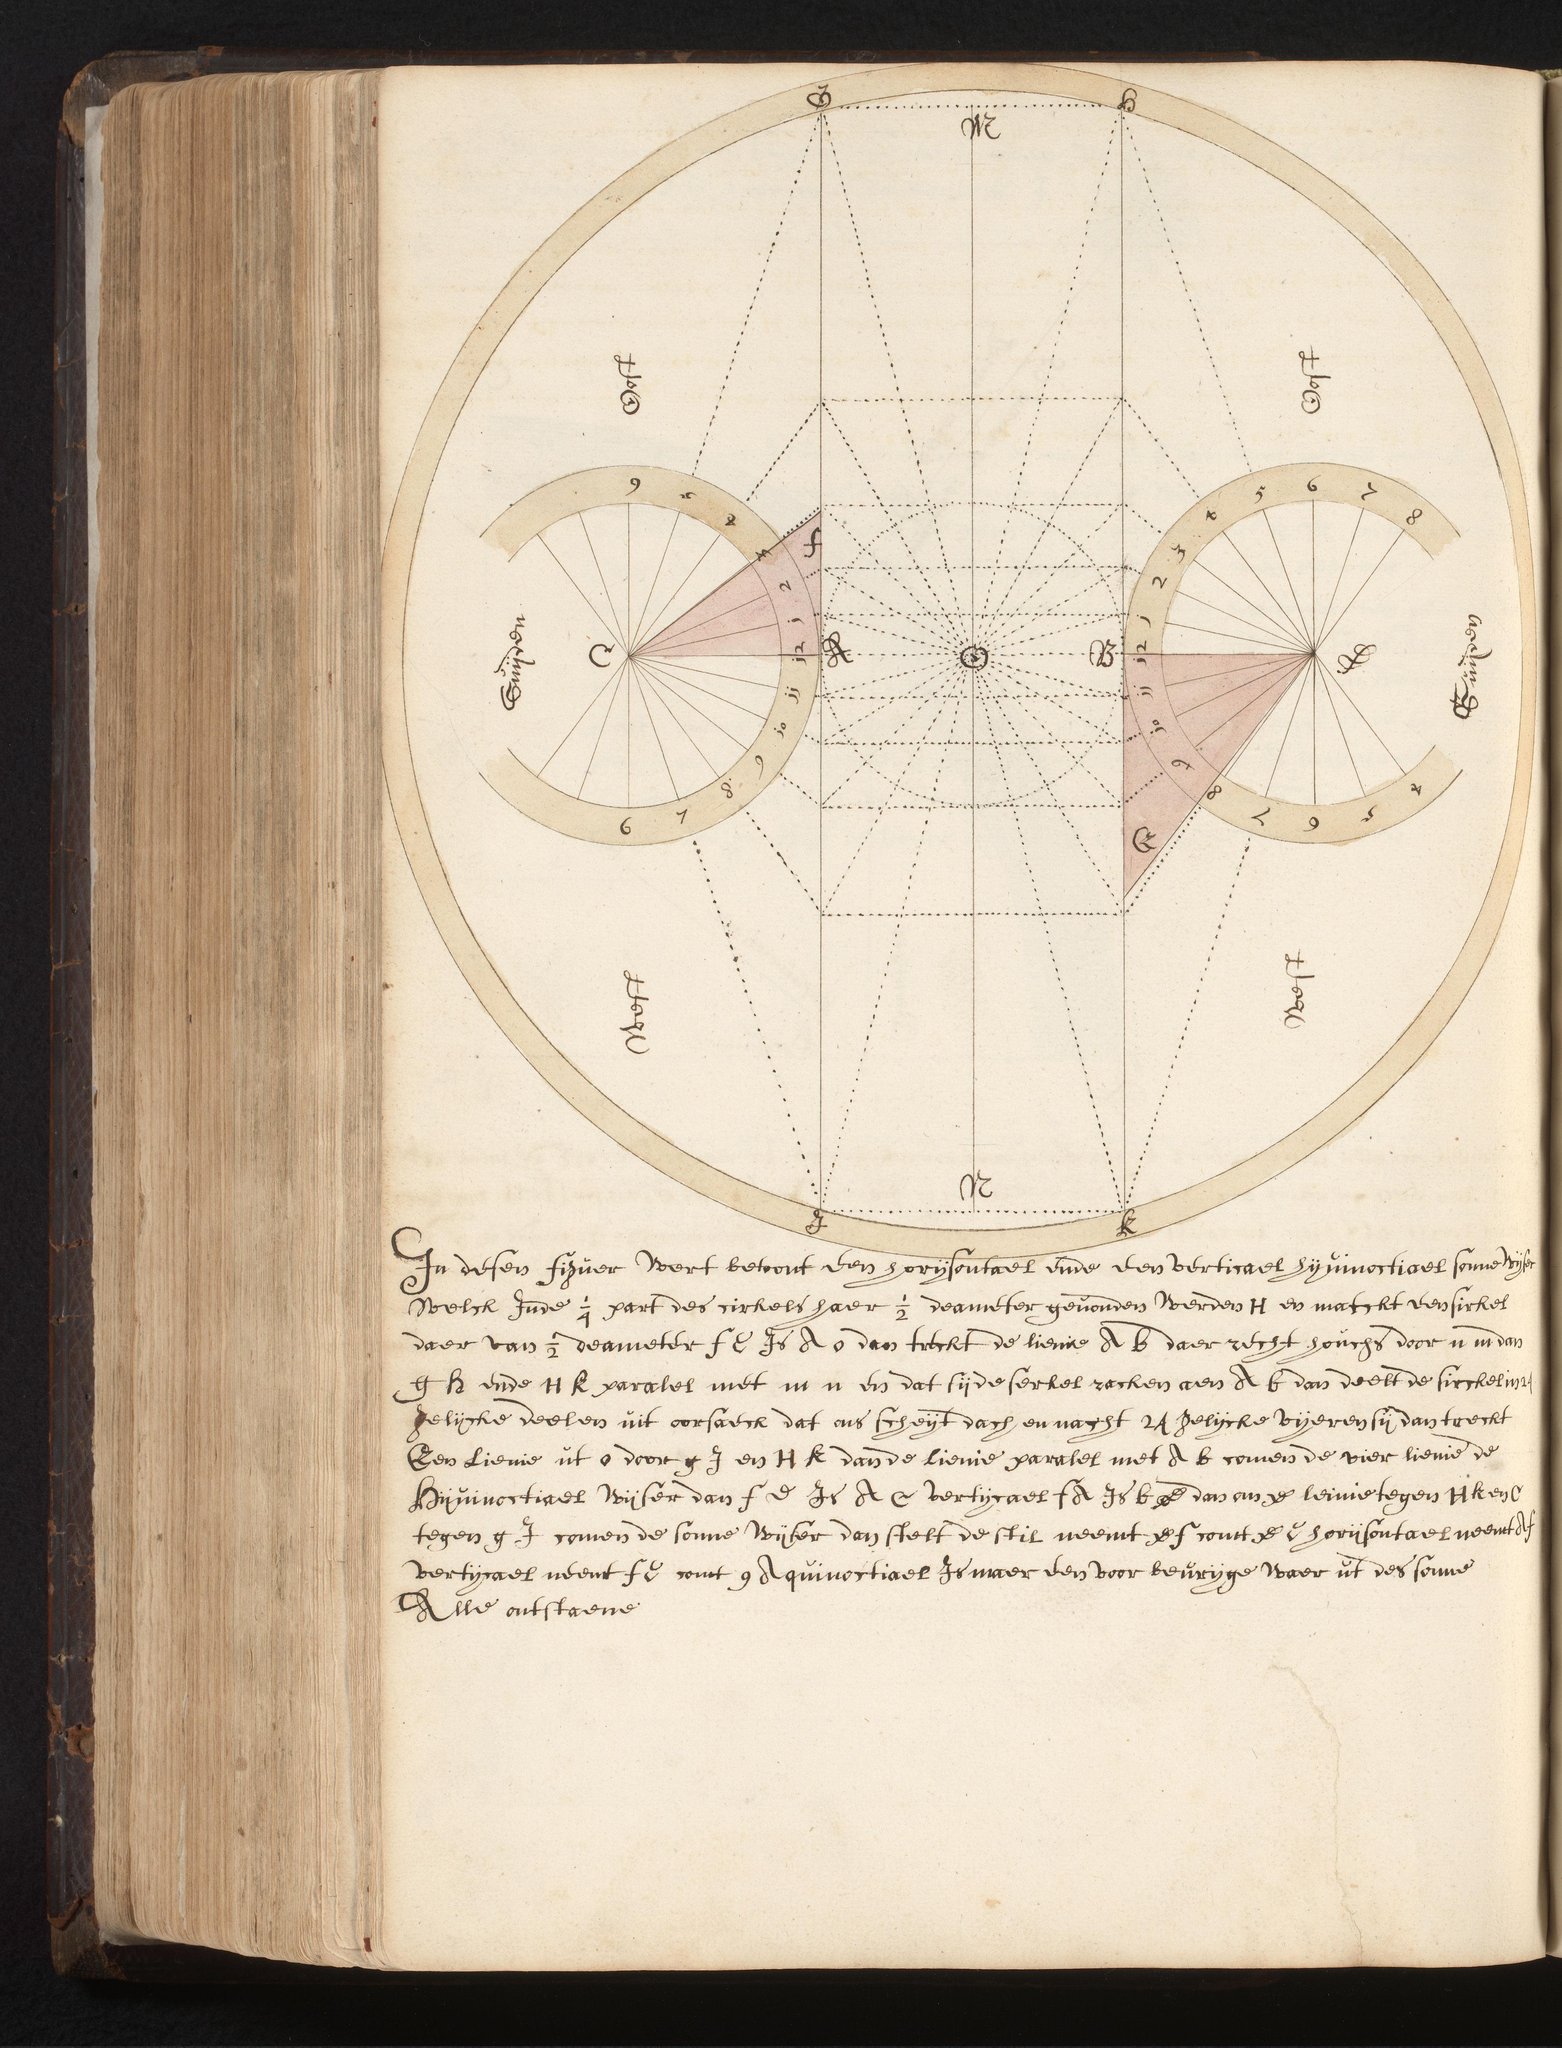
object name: drawing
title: Ontwerp voor een zonnewijzer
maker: Anonymous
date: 1650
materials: ink, paper, pencil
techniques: brush, pen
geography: low countries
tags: measuring, sundial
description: Met berekeningen. Tekening maakt deel uit van een album.